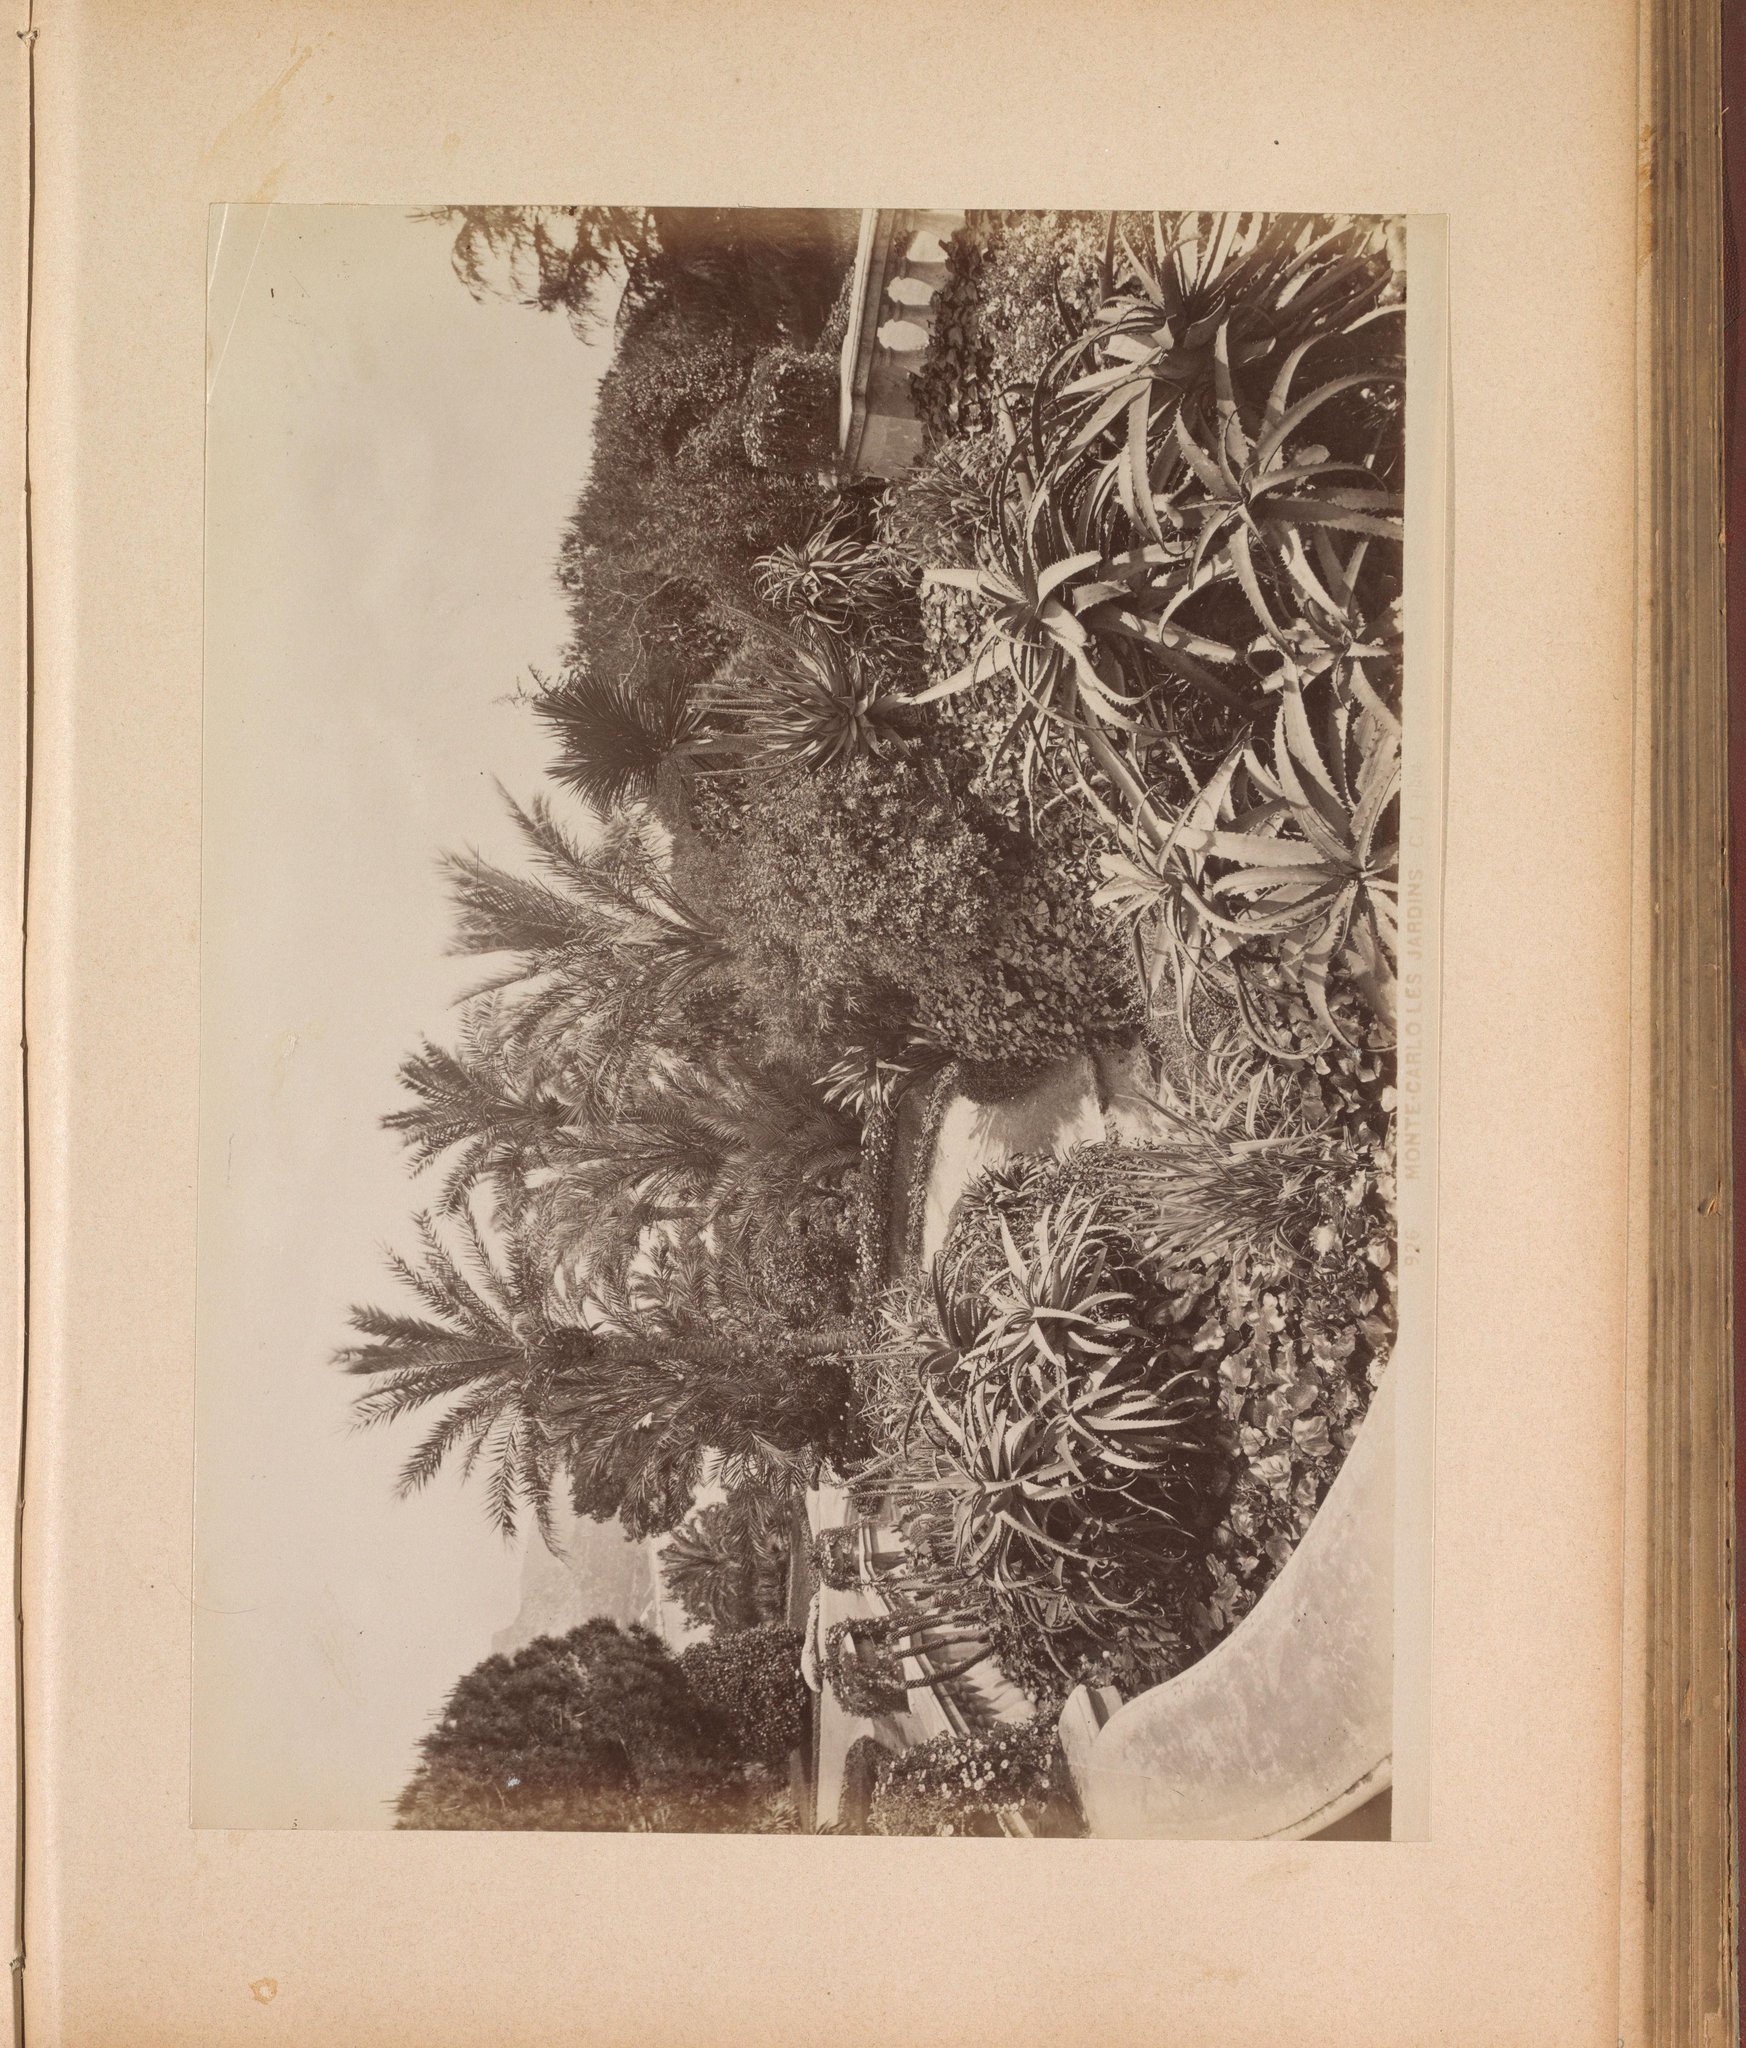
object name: album leaf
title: Gezicht op tuinen in Monte-Carlo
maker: jean gilletta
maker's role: fotograaf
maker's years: 1856-1933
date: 1870-1900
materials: paper, photographic support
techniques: albumen print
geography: monaco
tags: trees: palm-tree, plants and herbs: agave, public gardens, park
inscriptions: negative number: ‘926’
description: Onderdeel van Reisalbum met foto's van bezienswaardigheden in Italië en Zuid-Frankrijk.